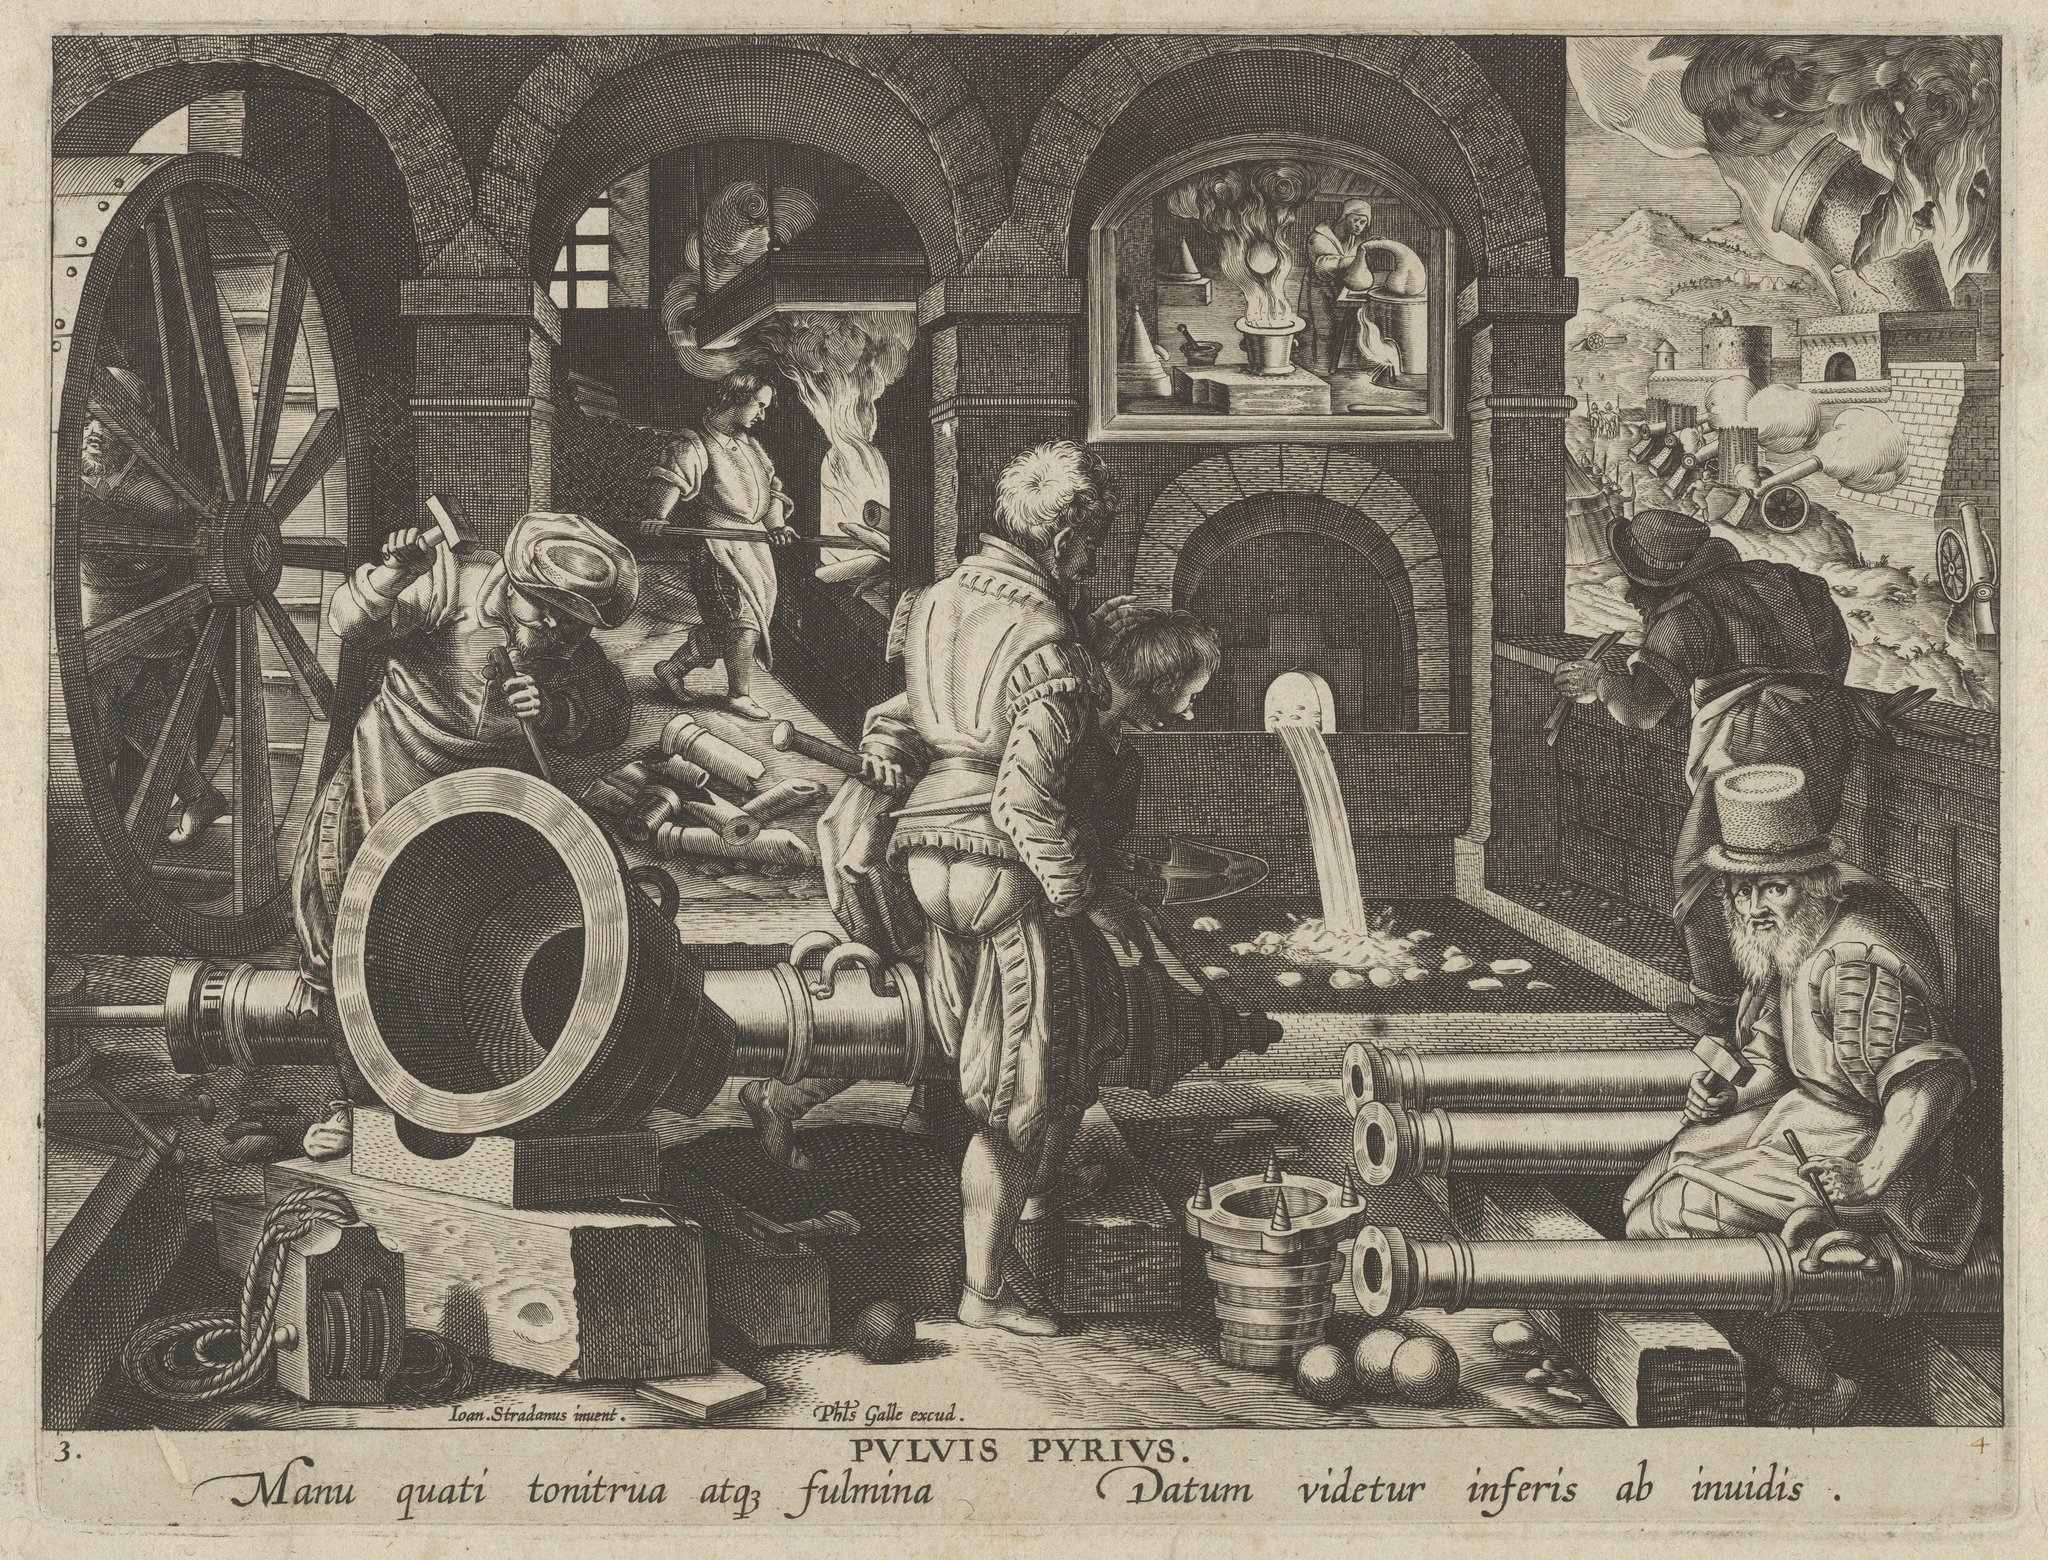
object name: print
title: New Inventions of Modern Times [Nova Reperta], The Invention of Gunpowder, plate 3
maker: jan collaert i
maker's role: artist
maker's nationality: netherlandish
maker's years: 1530-1581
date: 1600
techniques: engraving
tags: factories,cannons,men,working,industry